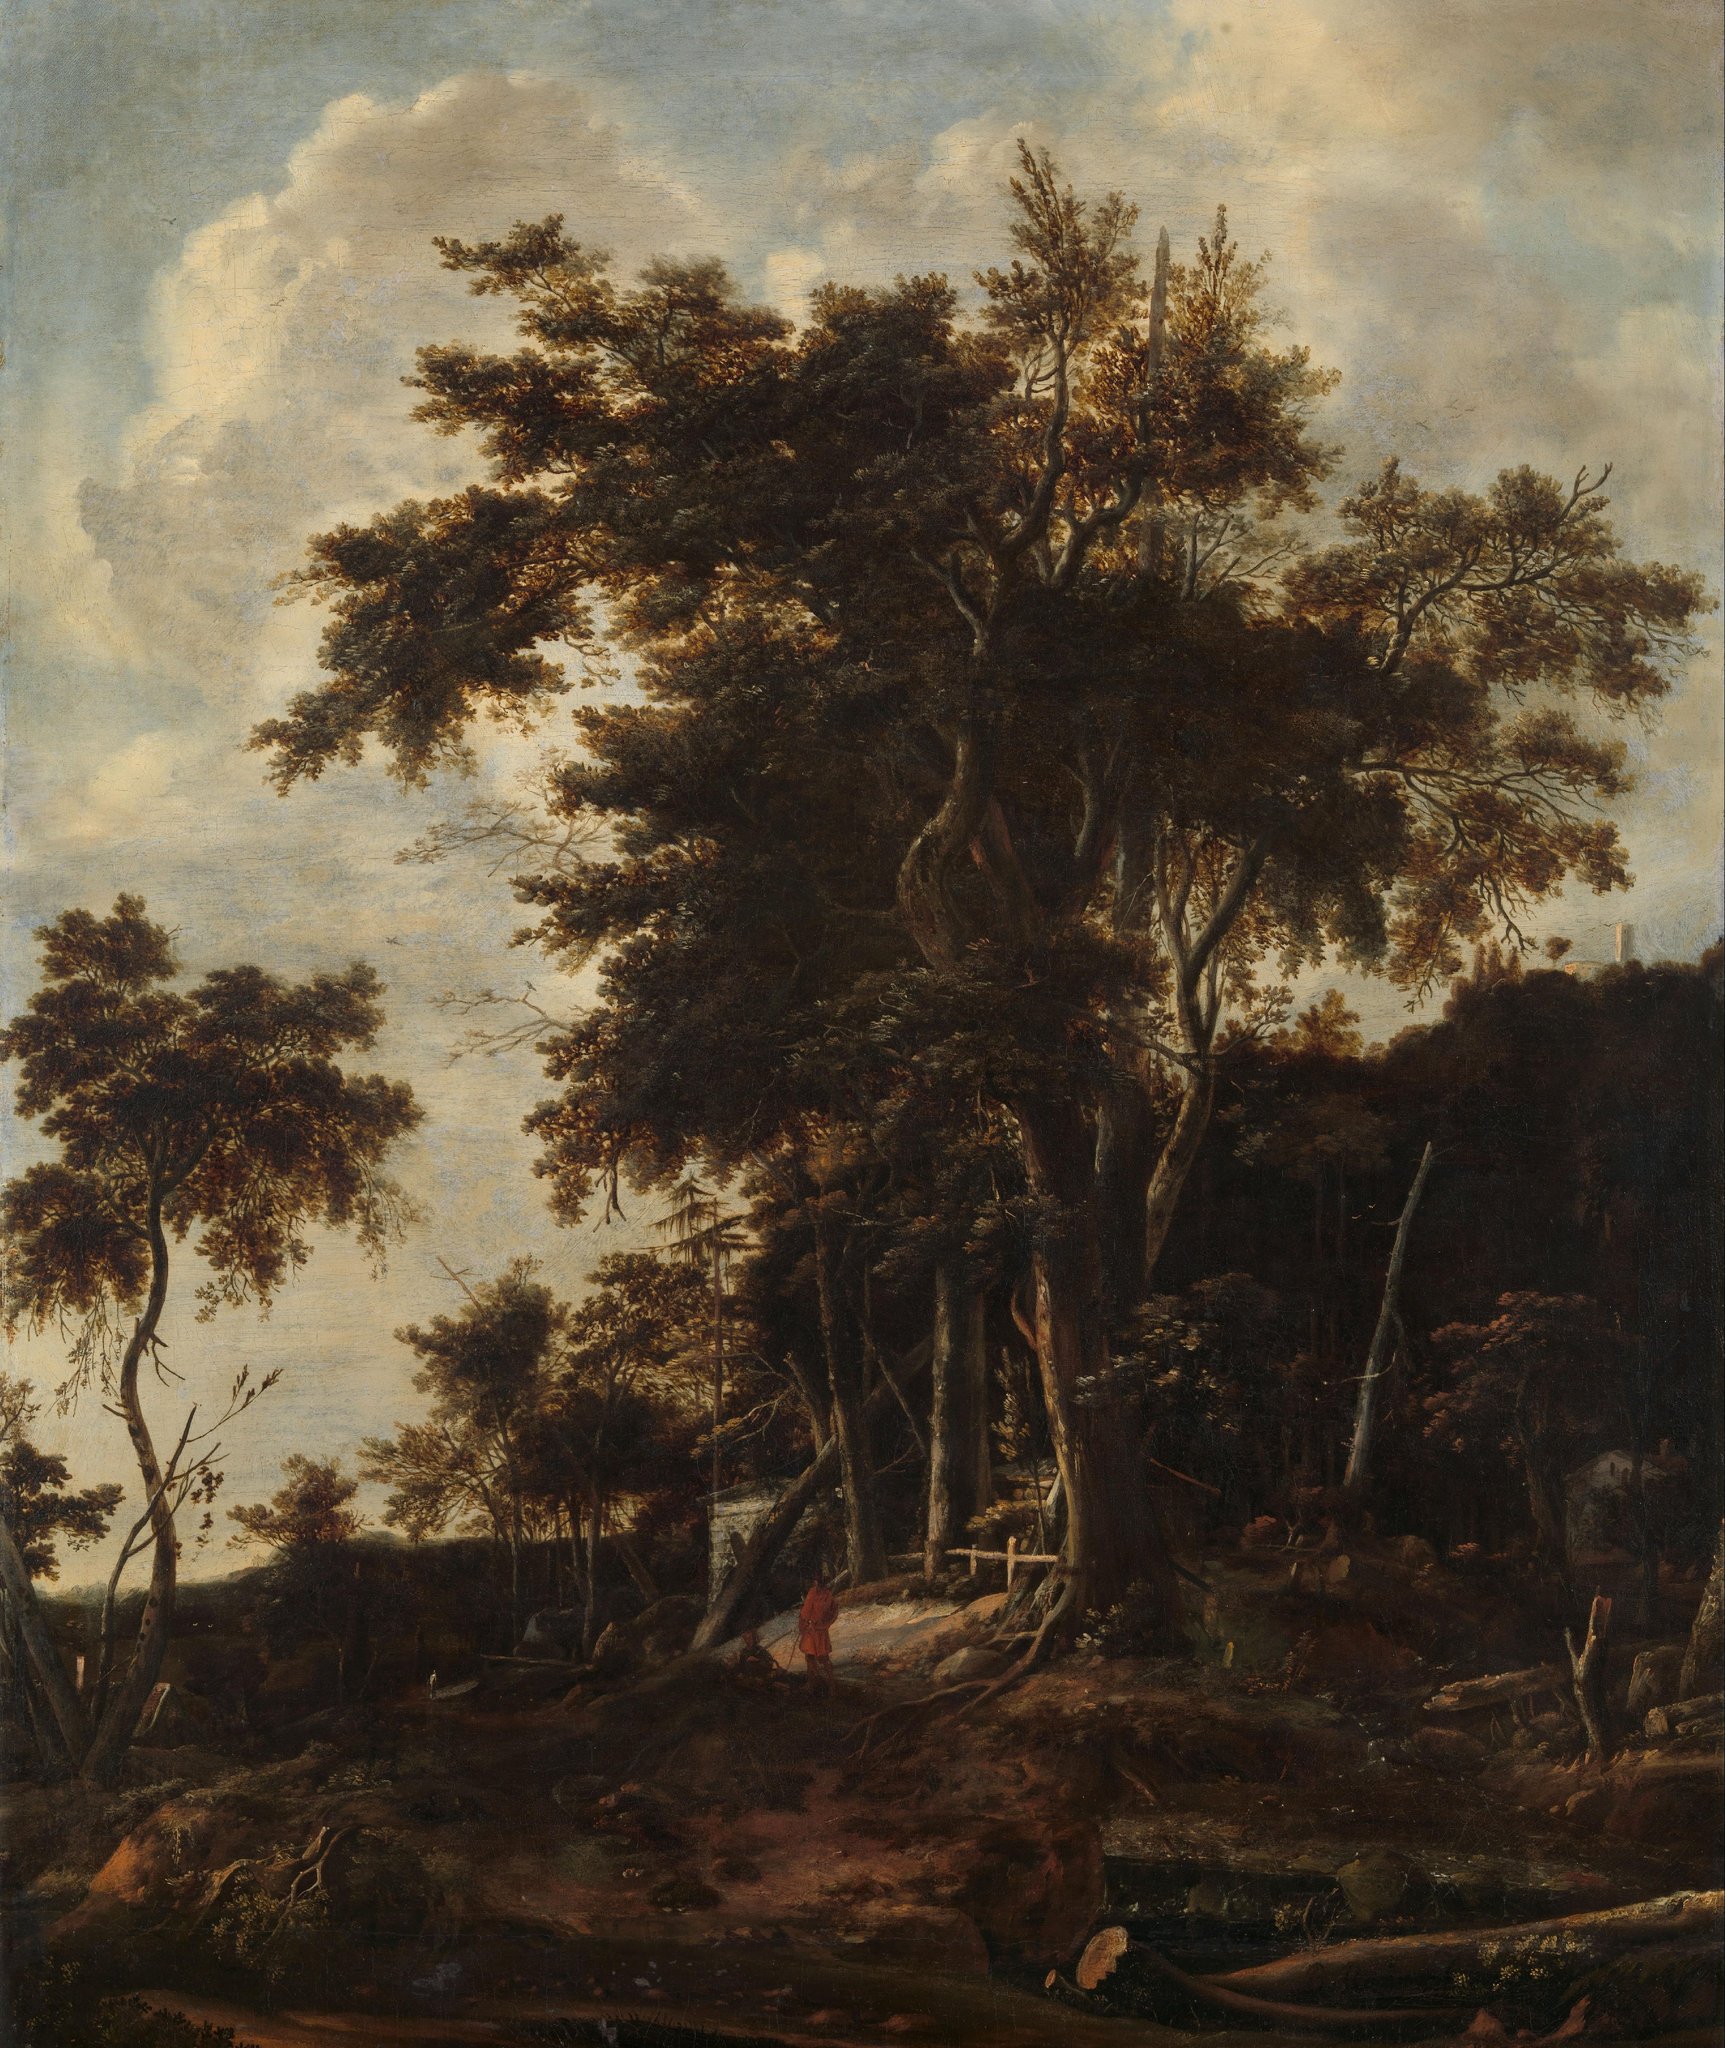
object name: painting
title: Forest landscape with a woodsman's shed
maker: roelant roghman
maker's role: draughtsman, painter, print maker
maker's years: 1627-1692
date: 1650-1692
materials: canvas, oil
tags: woodcutting, woodcutter ~ forestry, fringe, edge of the wood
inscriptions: signature: ‘R. Roghman f’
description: Boslandschap met hoge bomen en een houthakkerswoning. Op de grond liggen boomstammen, in het midden twee rustende mannen. Pendant van SK-A-2363.